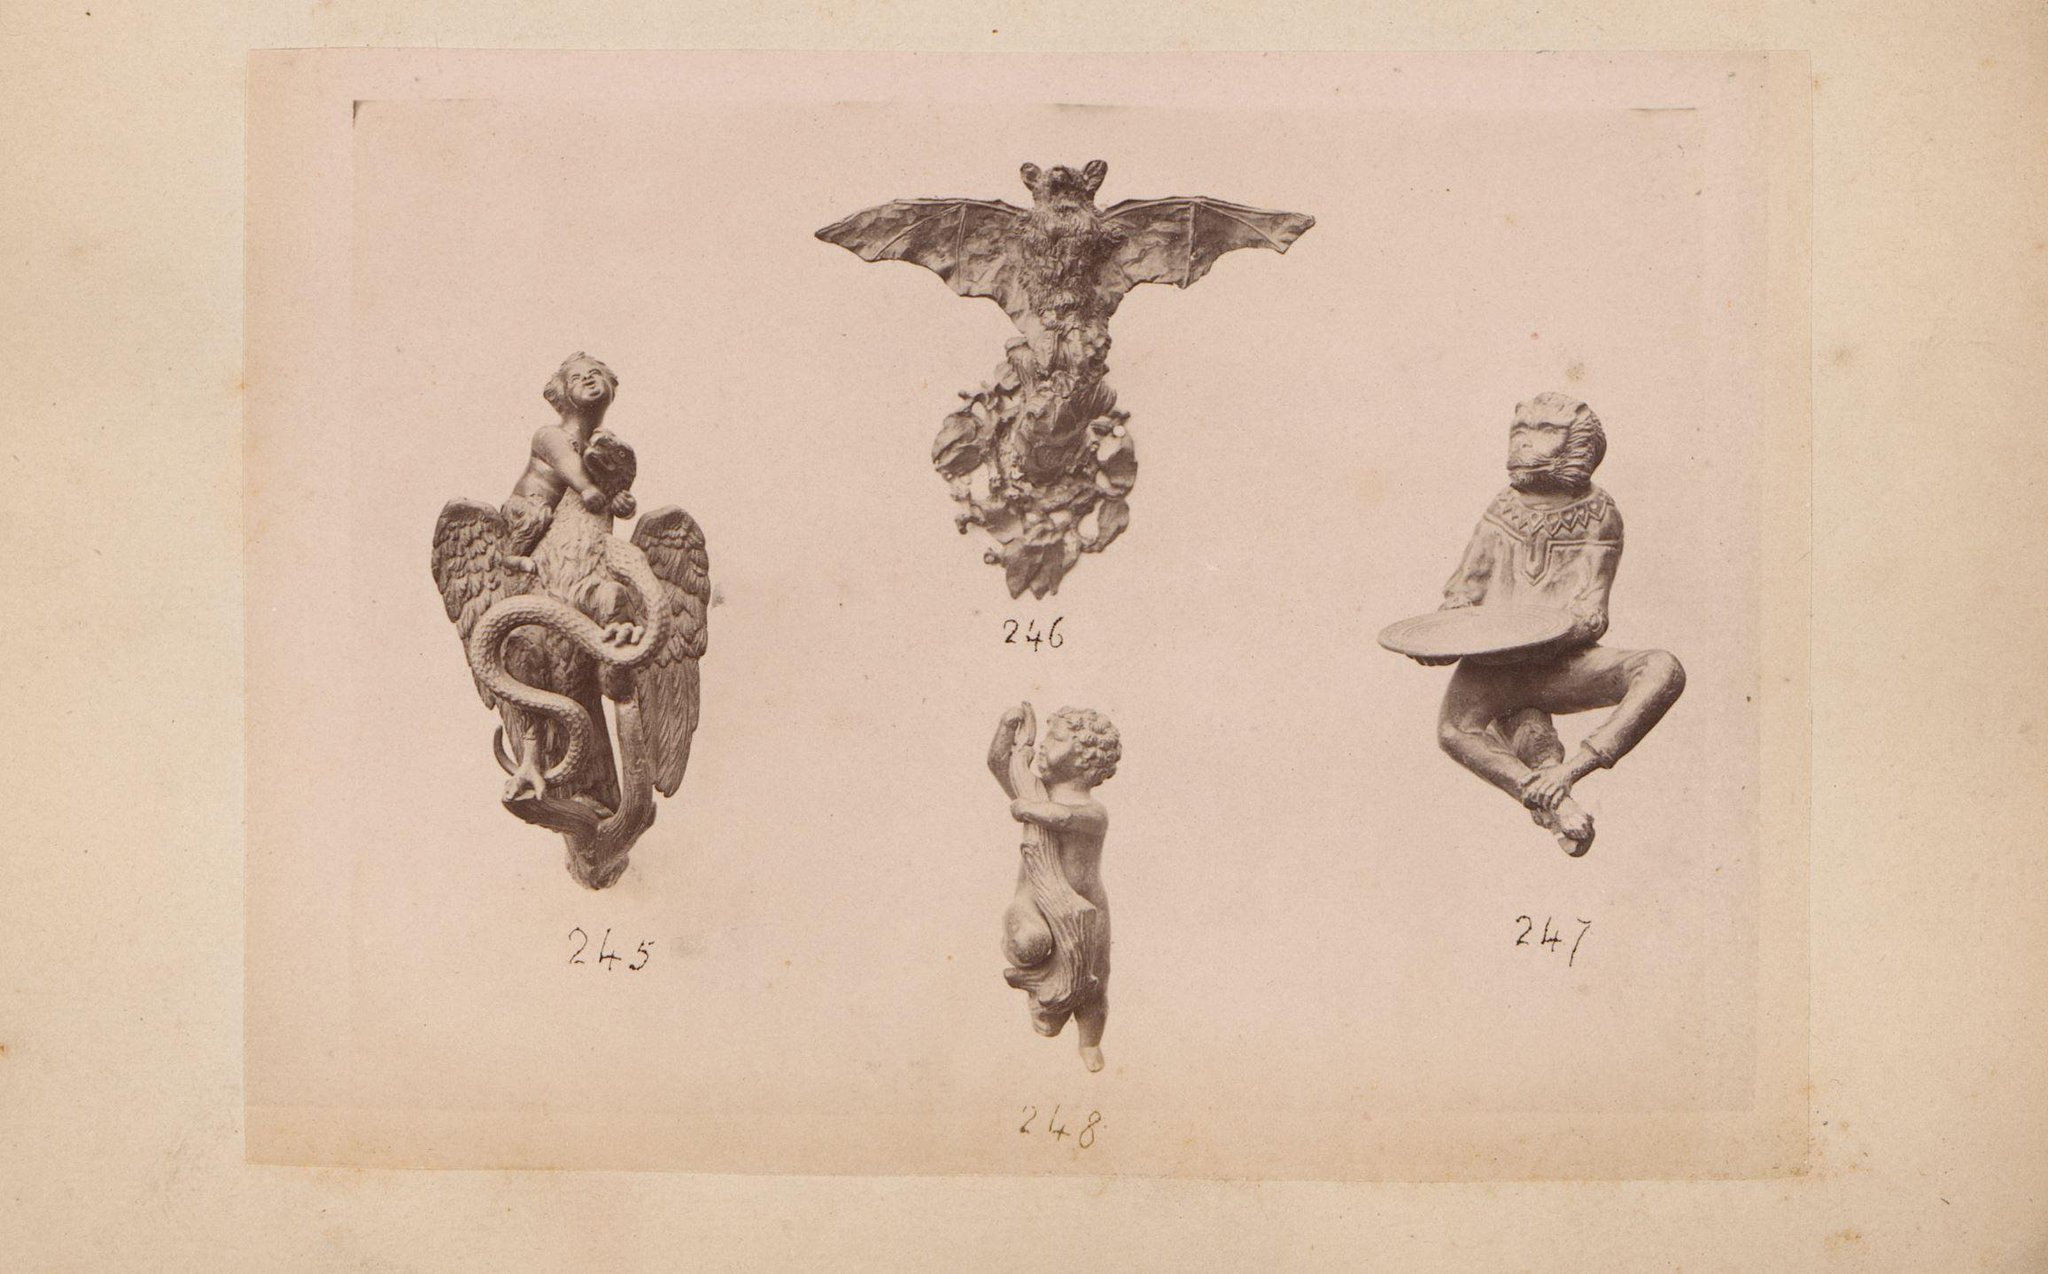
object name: photograph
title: Metalen sculpturen van een vleermuis, een aap en naakten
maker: Anonymous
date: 1860-1885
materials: photographic support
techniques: albumen print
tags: sculpture